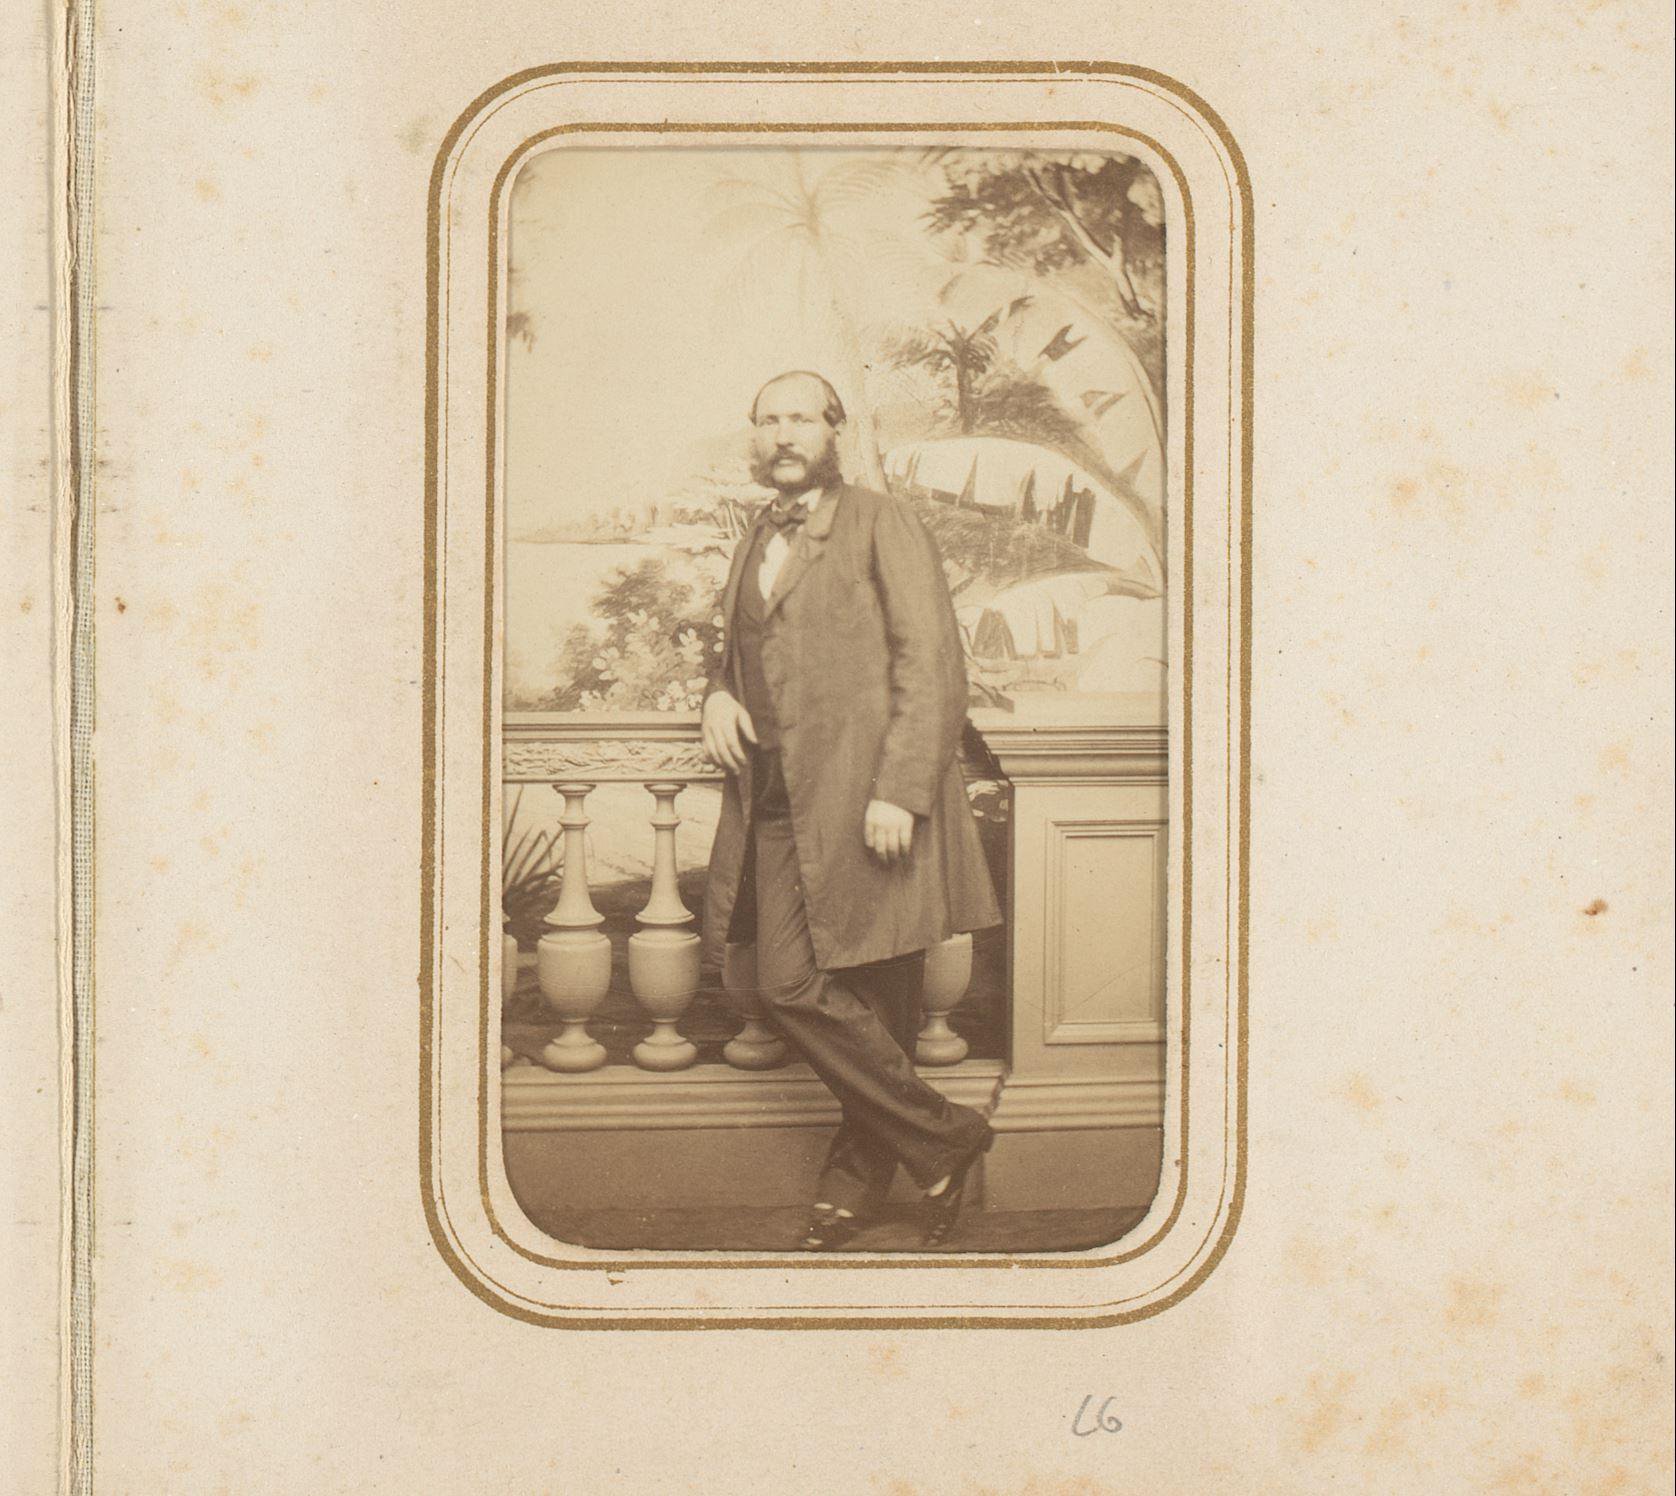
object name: photograph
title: Portret van een man, aangeduid als Jules la Combe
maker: Anonymous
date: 1850-1880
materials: cardboard, photographic support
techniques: albumen print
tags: sideburns, historical persons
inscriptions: name: ‘Jules la Combe’